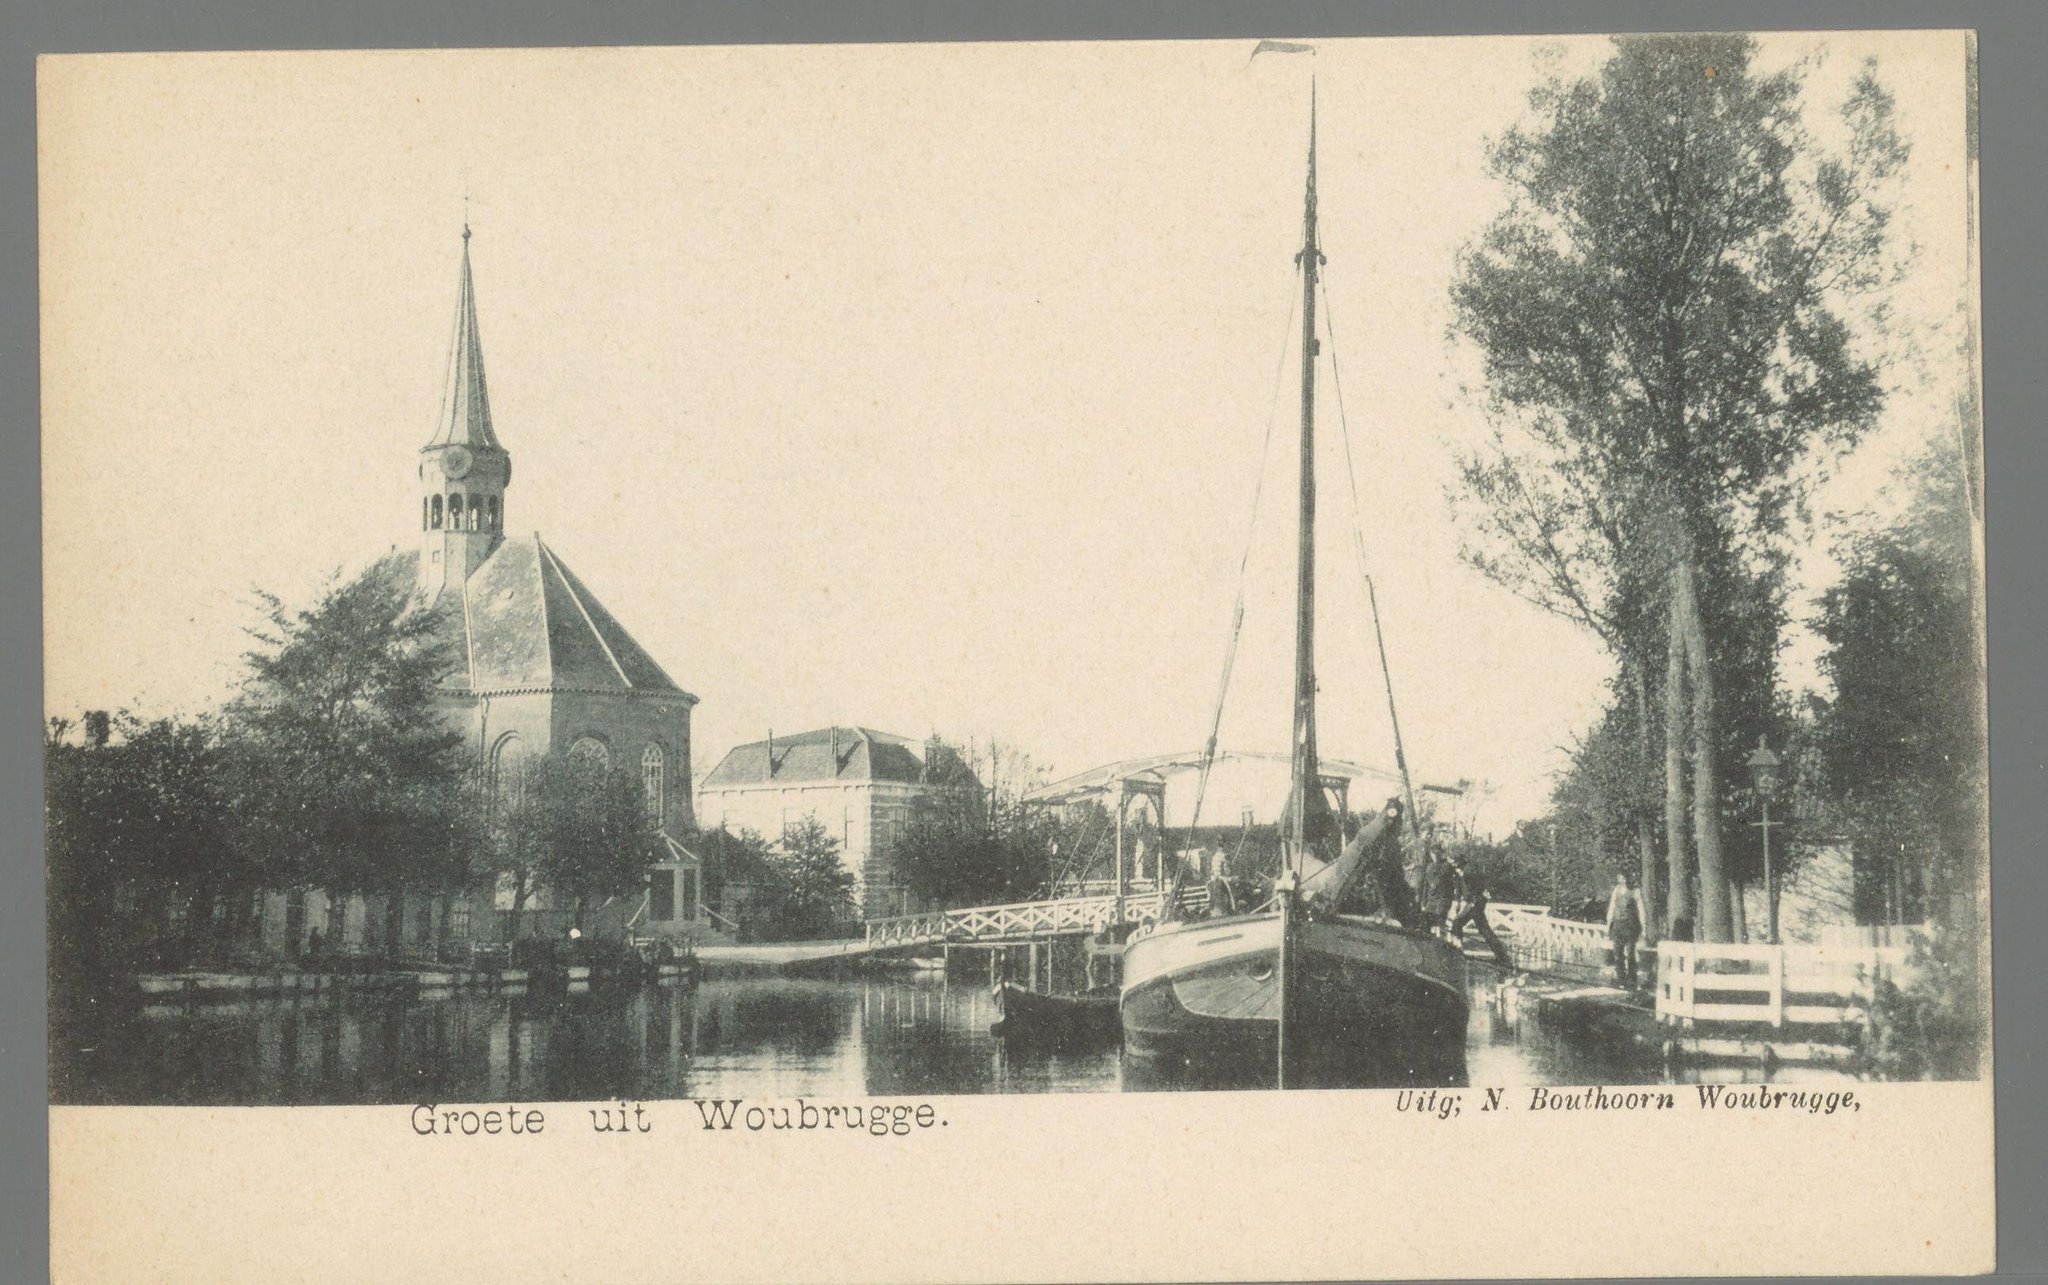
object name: ansichtkaart, prentbriefkaart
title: Groete uit Woubrugge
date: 1897-1905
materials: cardboard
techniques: photograph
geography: woubrugge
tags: city-view, and landscape with man-made constructions, sailing-ship, sailing-boat, canals, waters (in village), church (exterior), bridge in village across river, canal, etc.